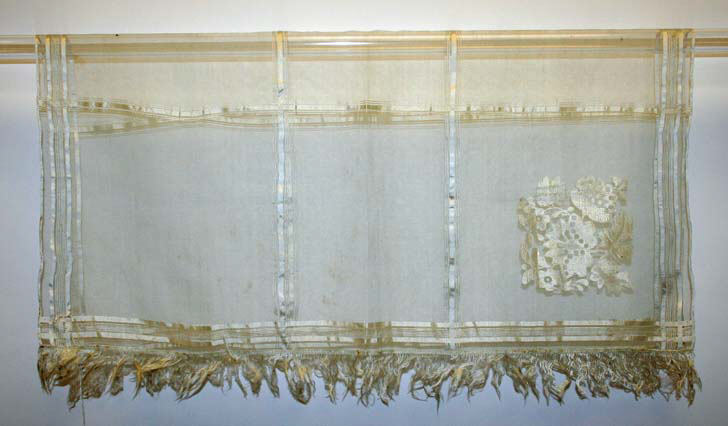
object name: scarf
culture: european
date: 1820-1839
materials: silk